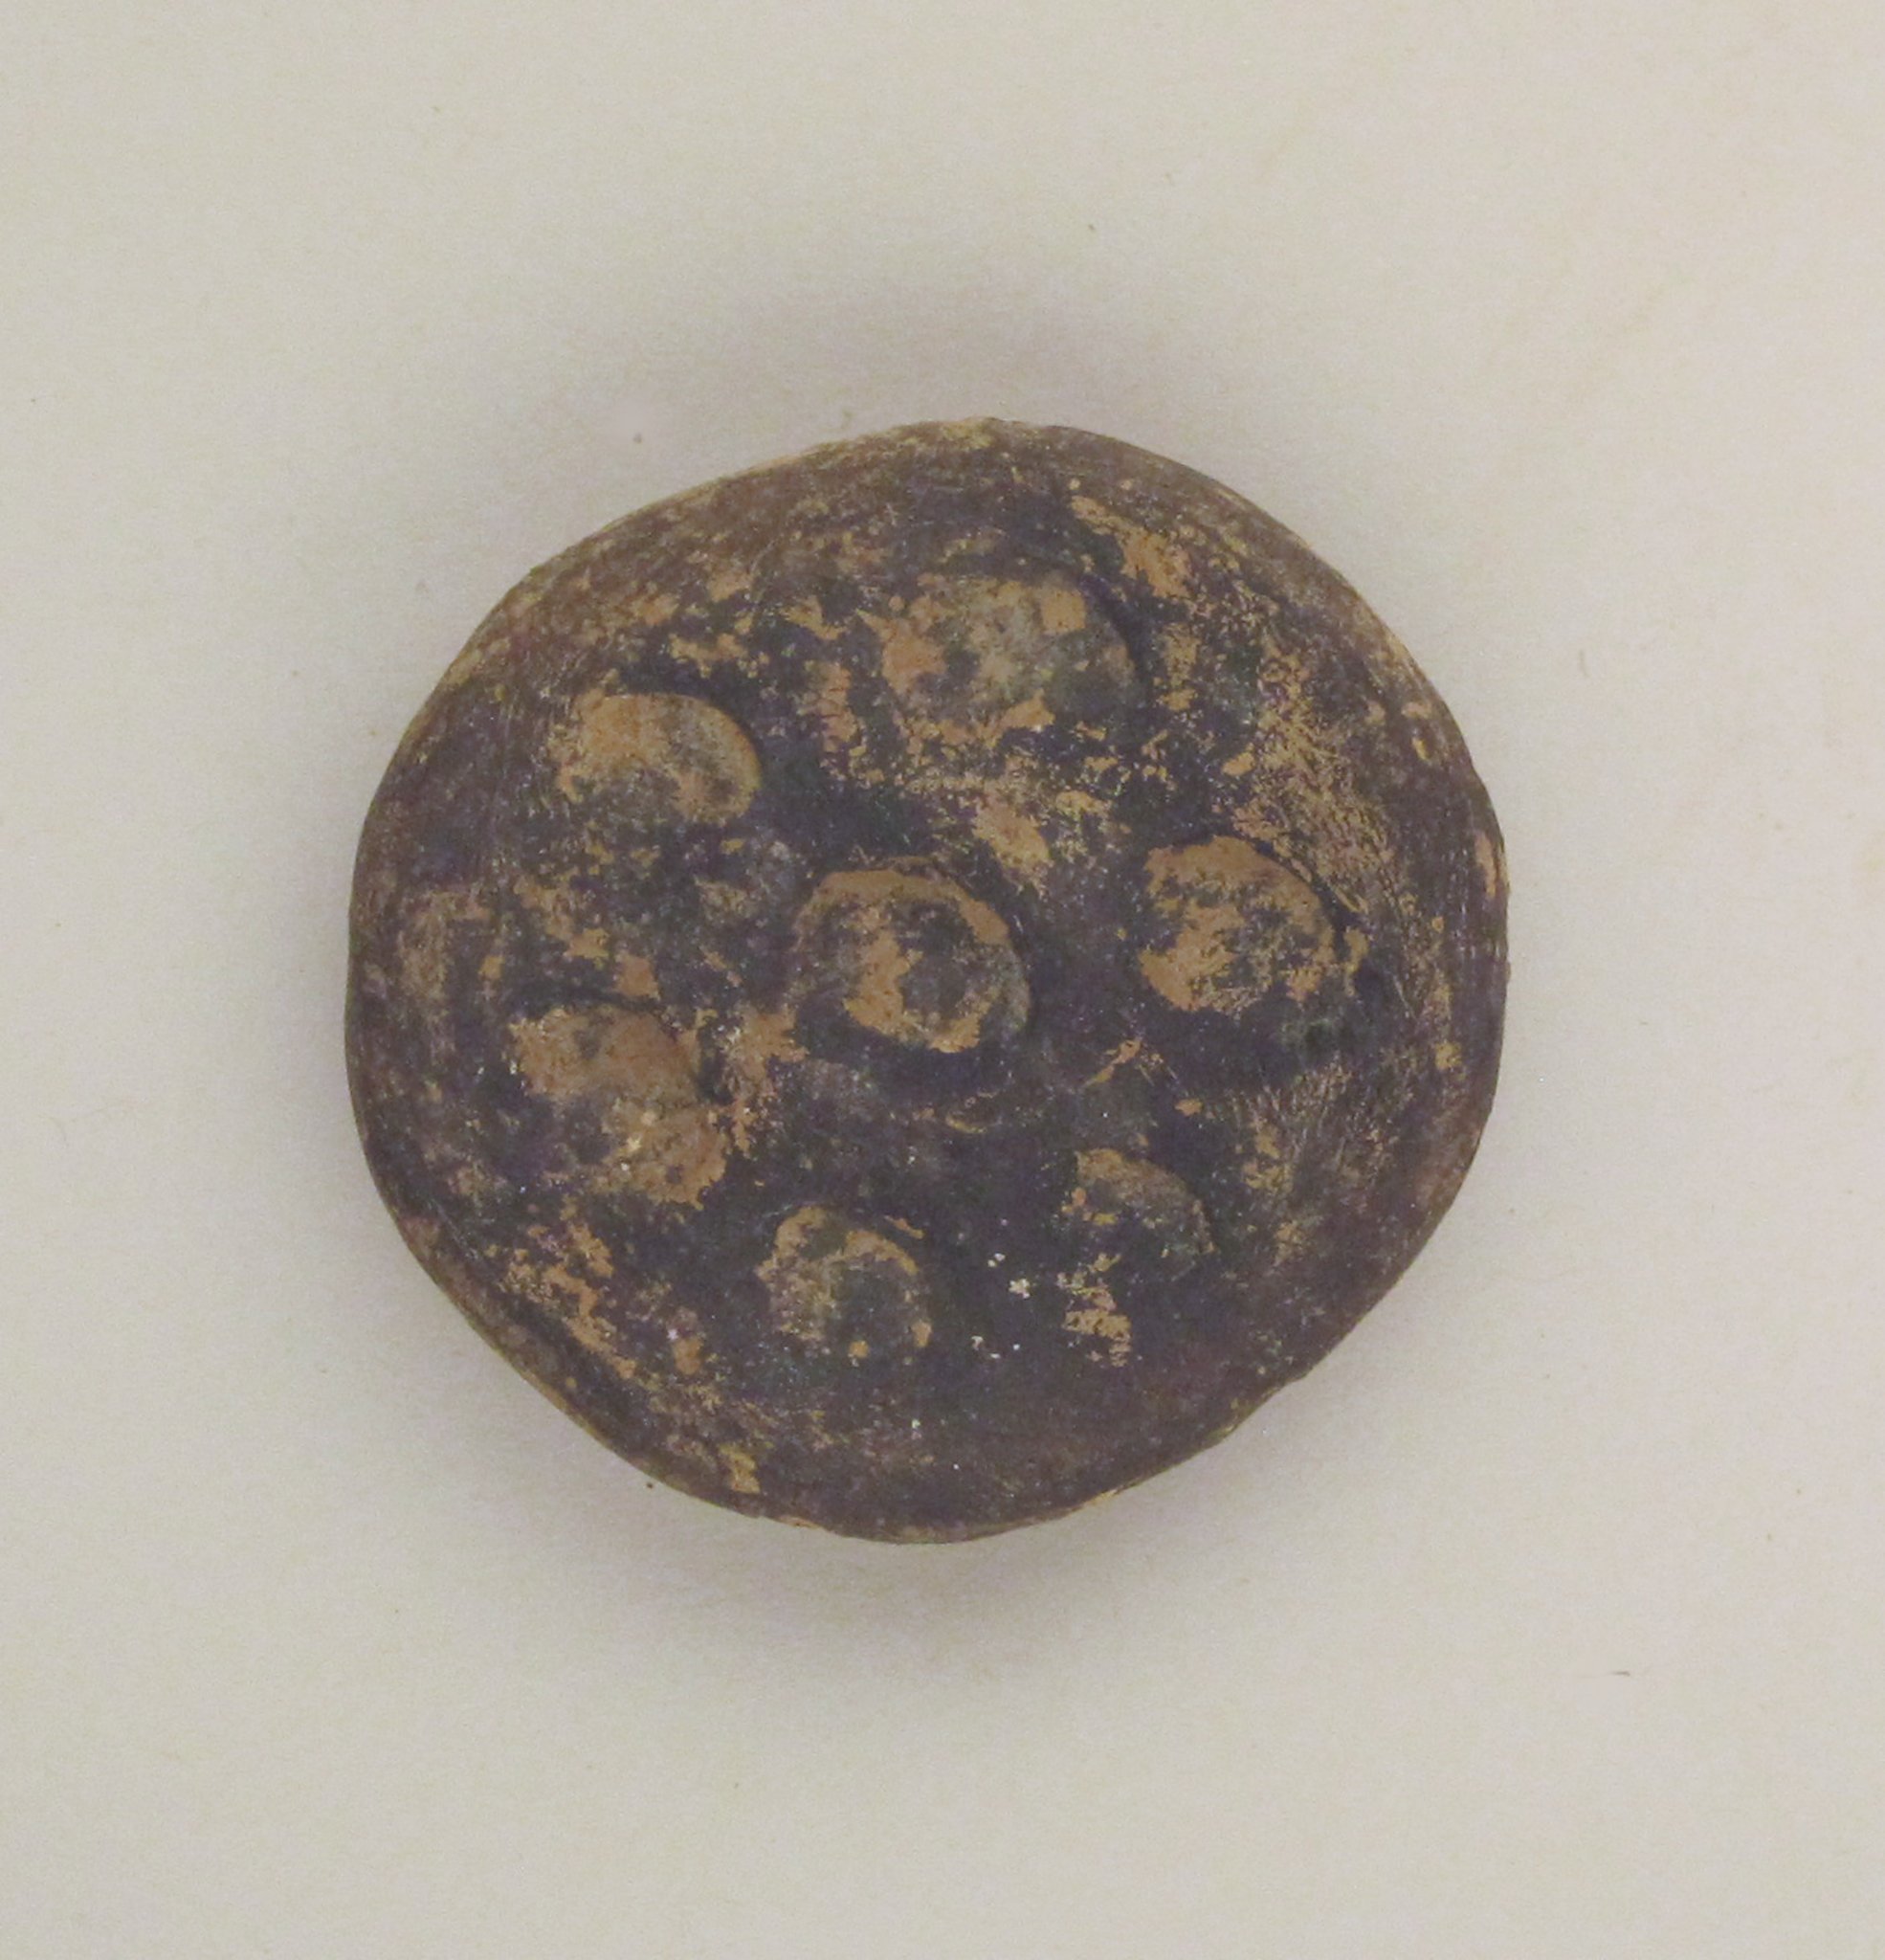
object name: phiale, miniature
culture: greek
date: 7000-30 BCE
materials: terracotta